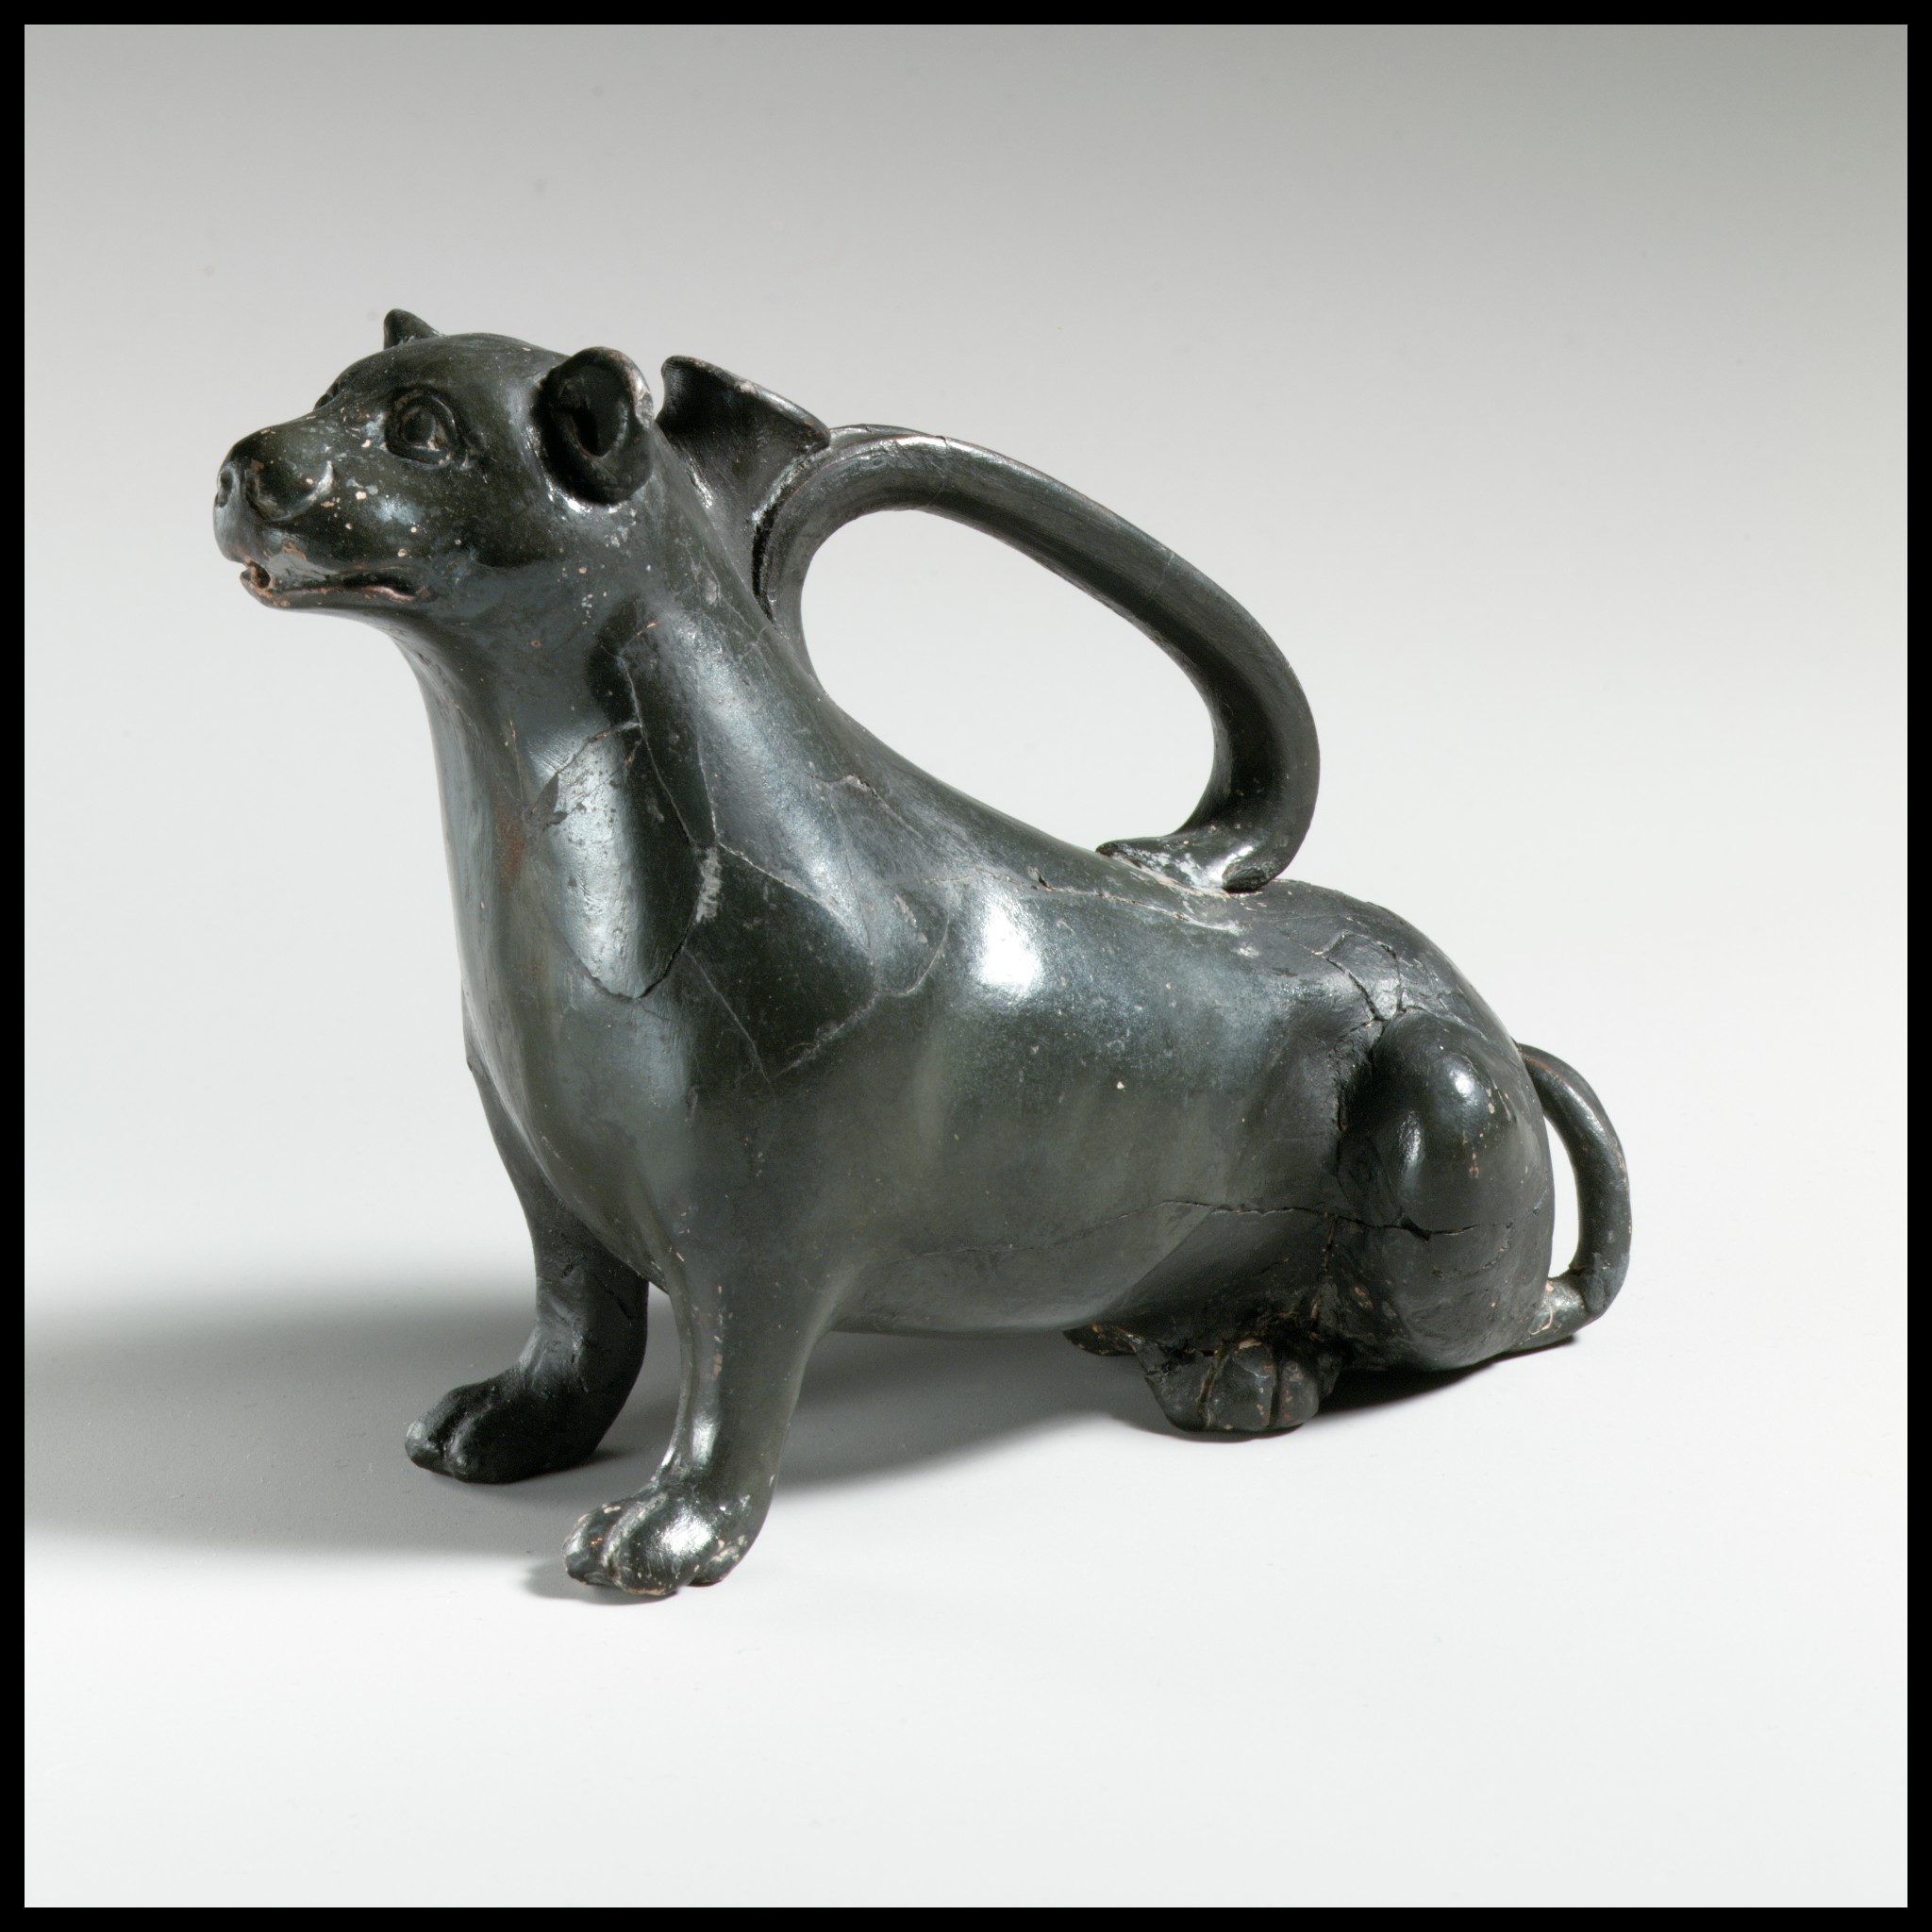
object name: askos in the form of a weasel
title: Terracotta askos in the form of a weasel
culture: greek or south italian or campanian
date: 400-301 BCE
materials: terracotta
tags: animals